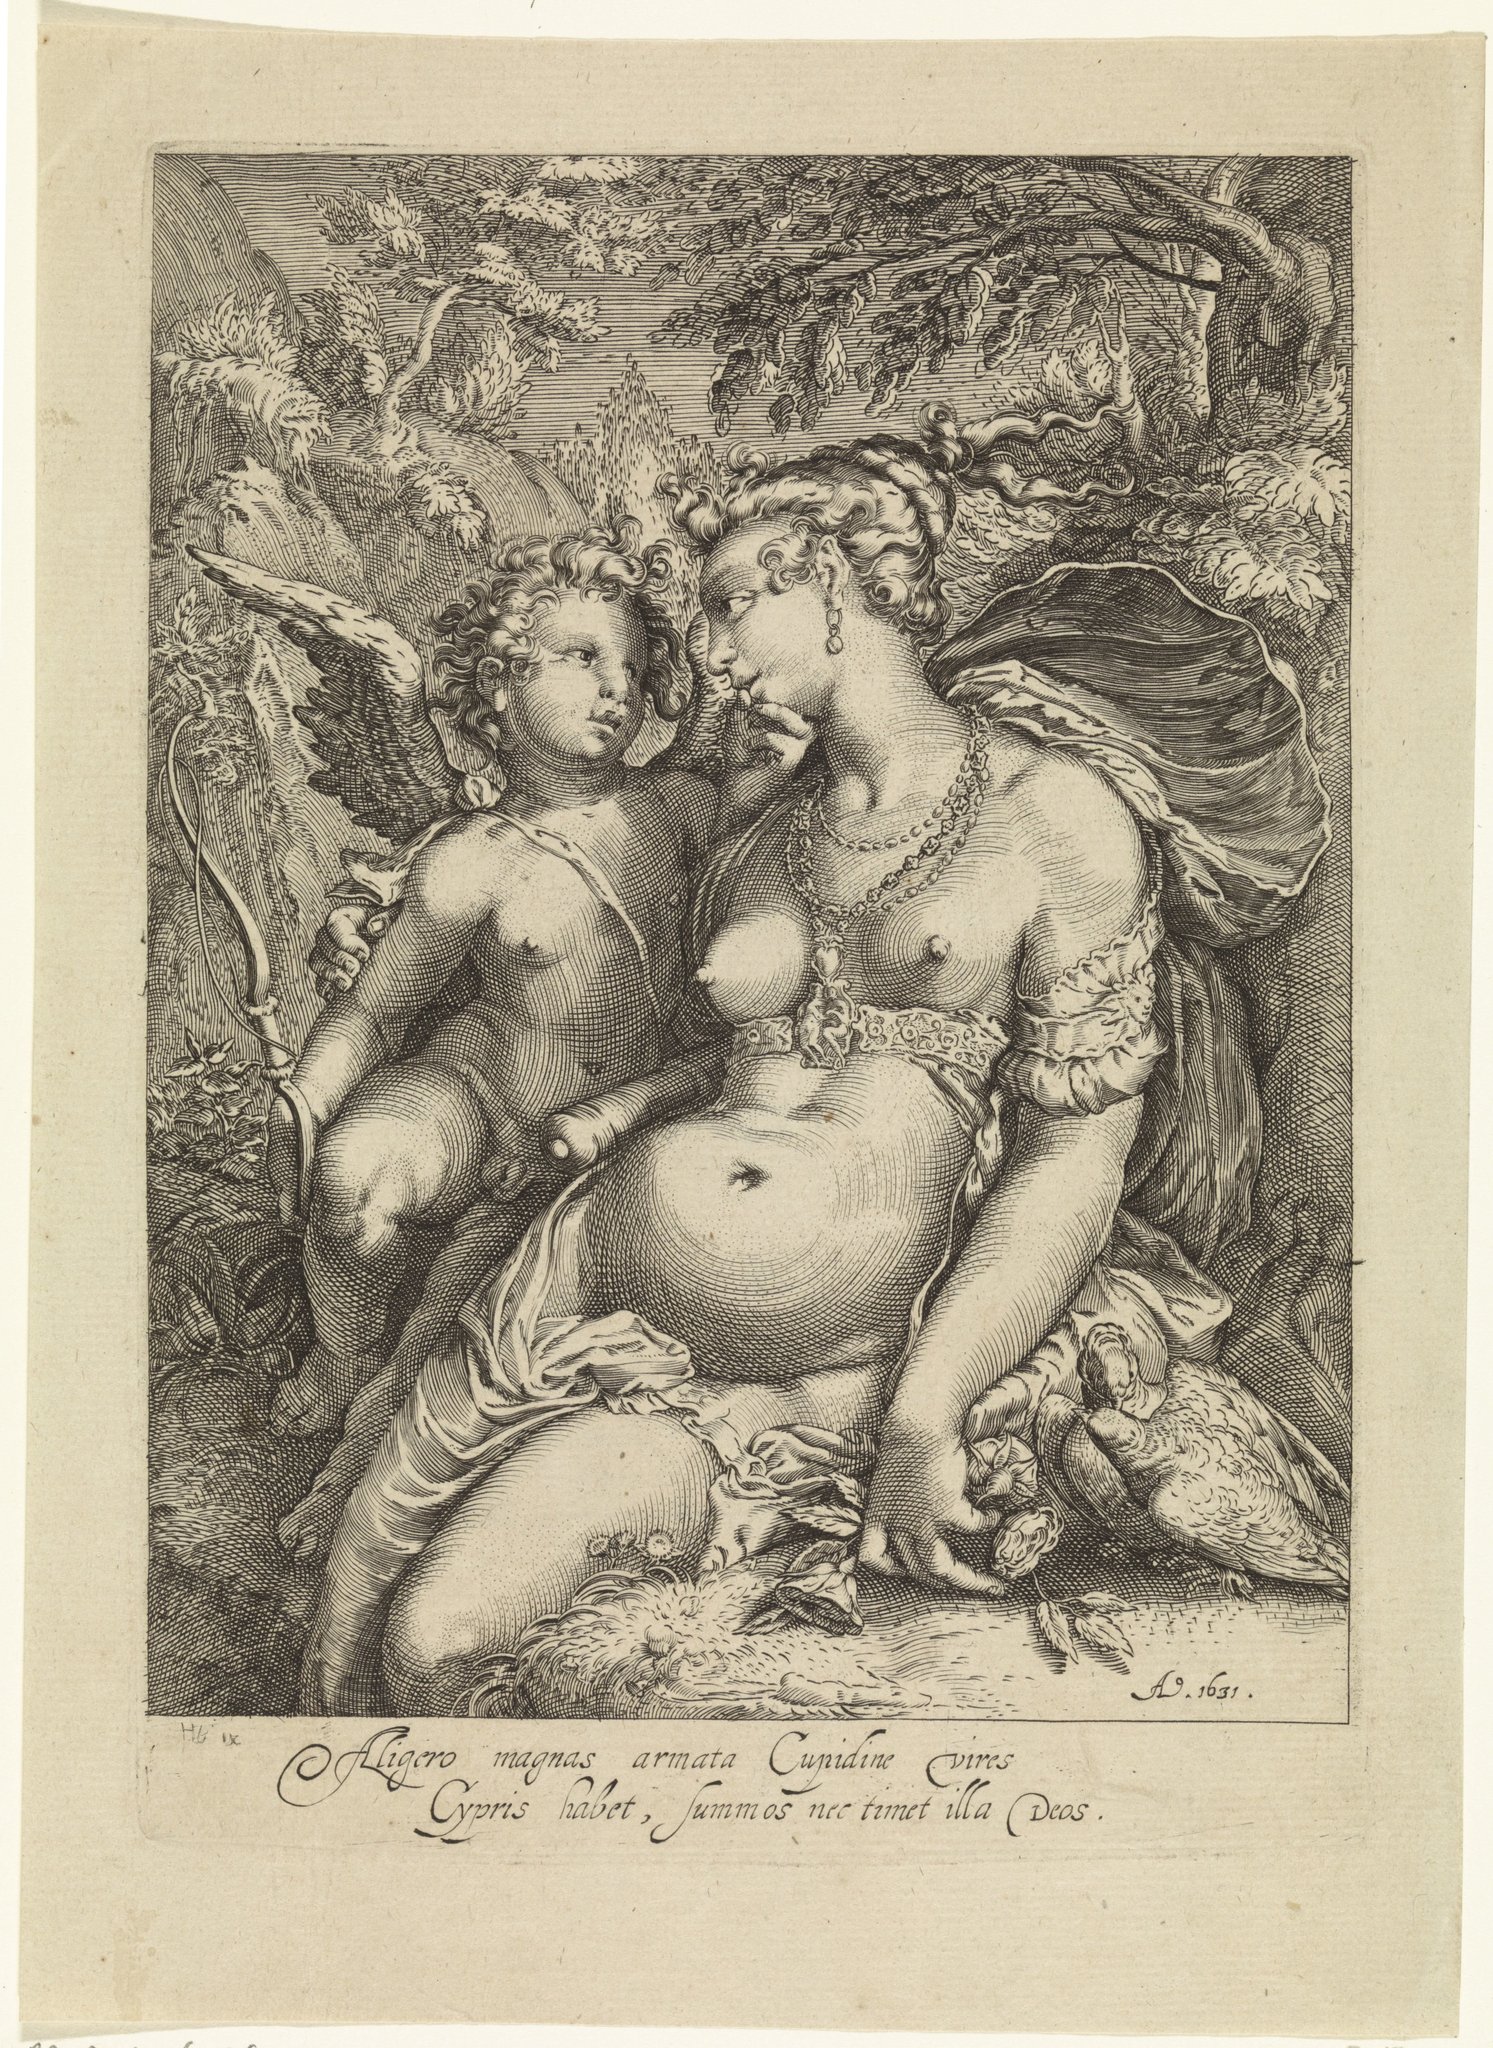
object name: print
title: Venus en Amor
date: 1631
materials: paper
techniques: engraving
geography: northern netherlands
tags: other birds: dove (+ animals used symbolically), lovers; courting, flirting, venus and cupid (cupid not being mere attribute), mountains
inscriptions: collector's mark: Lugt 2228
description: Venus zittend bij een boom in een bergachtig landschap. Naast haar is Amor met zijn pijl en boog verschenen en streelt haar kin. Rechts op de voorgrond twee snavelende duiven.